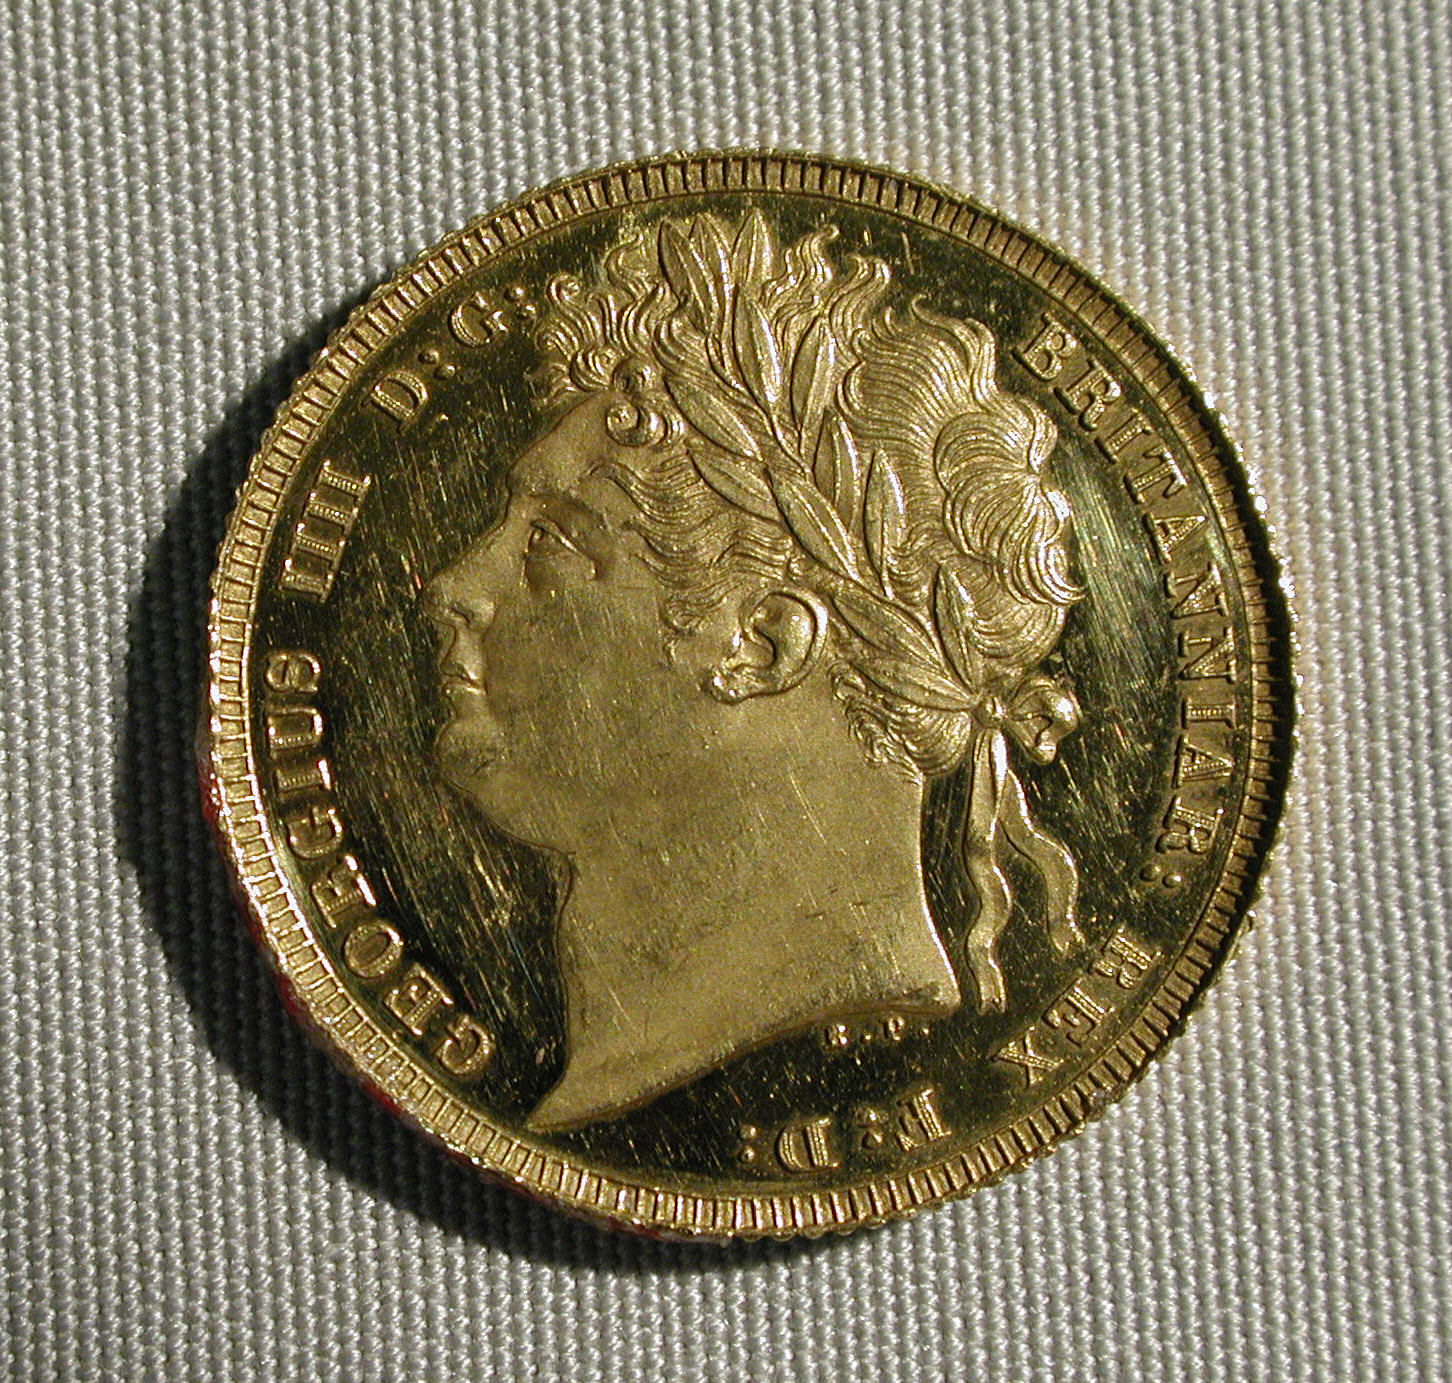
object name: proof sovereign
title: Proof sovereign of George IV (coronation year)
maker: benedetto pistrucci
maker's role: modeler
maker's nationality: italian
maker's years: 1783-1855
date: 1821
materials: gold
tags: swords,profiles,dragons,horses